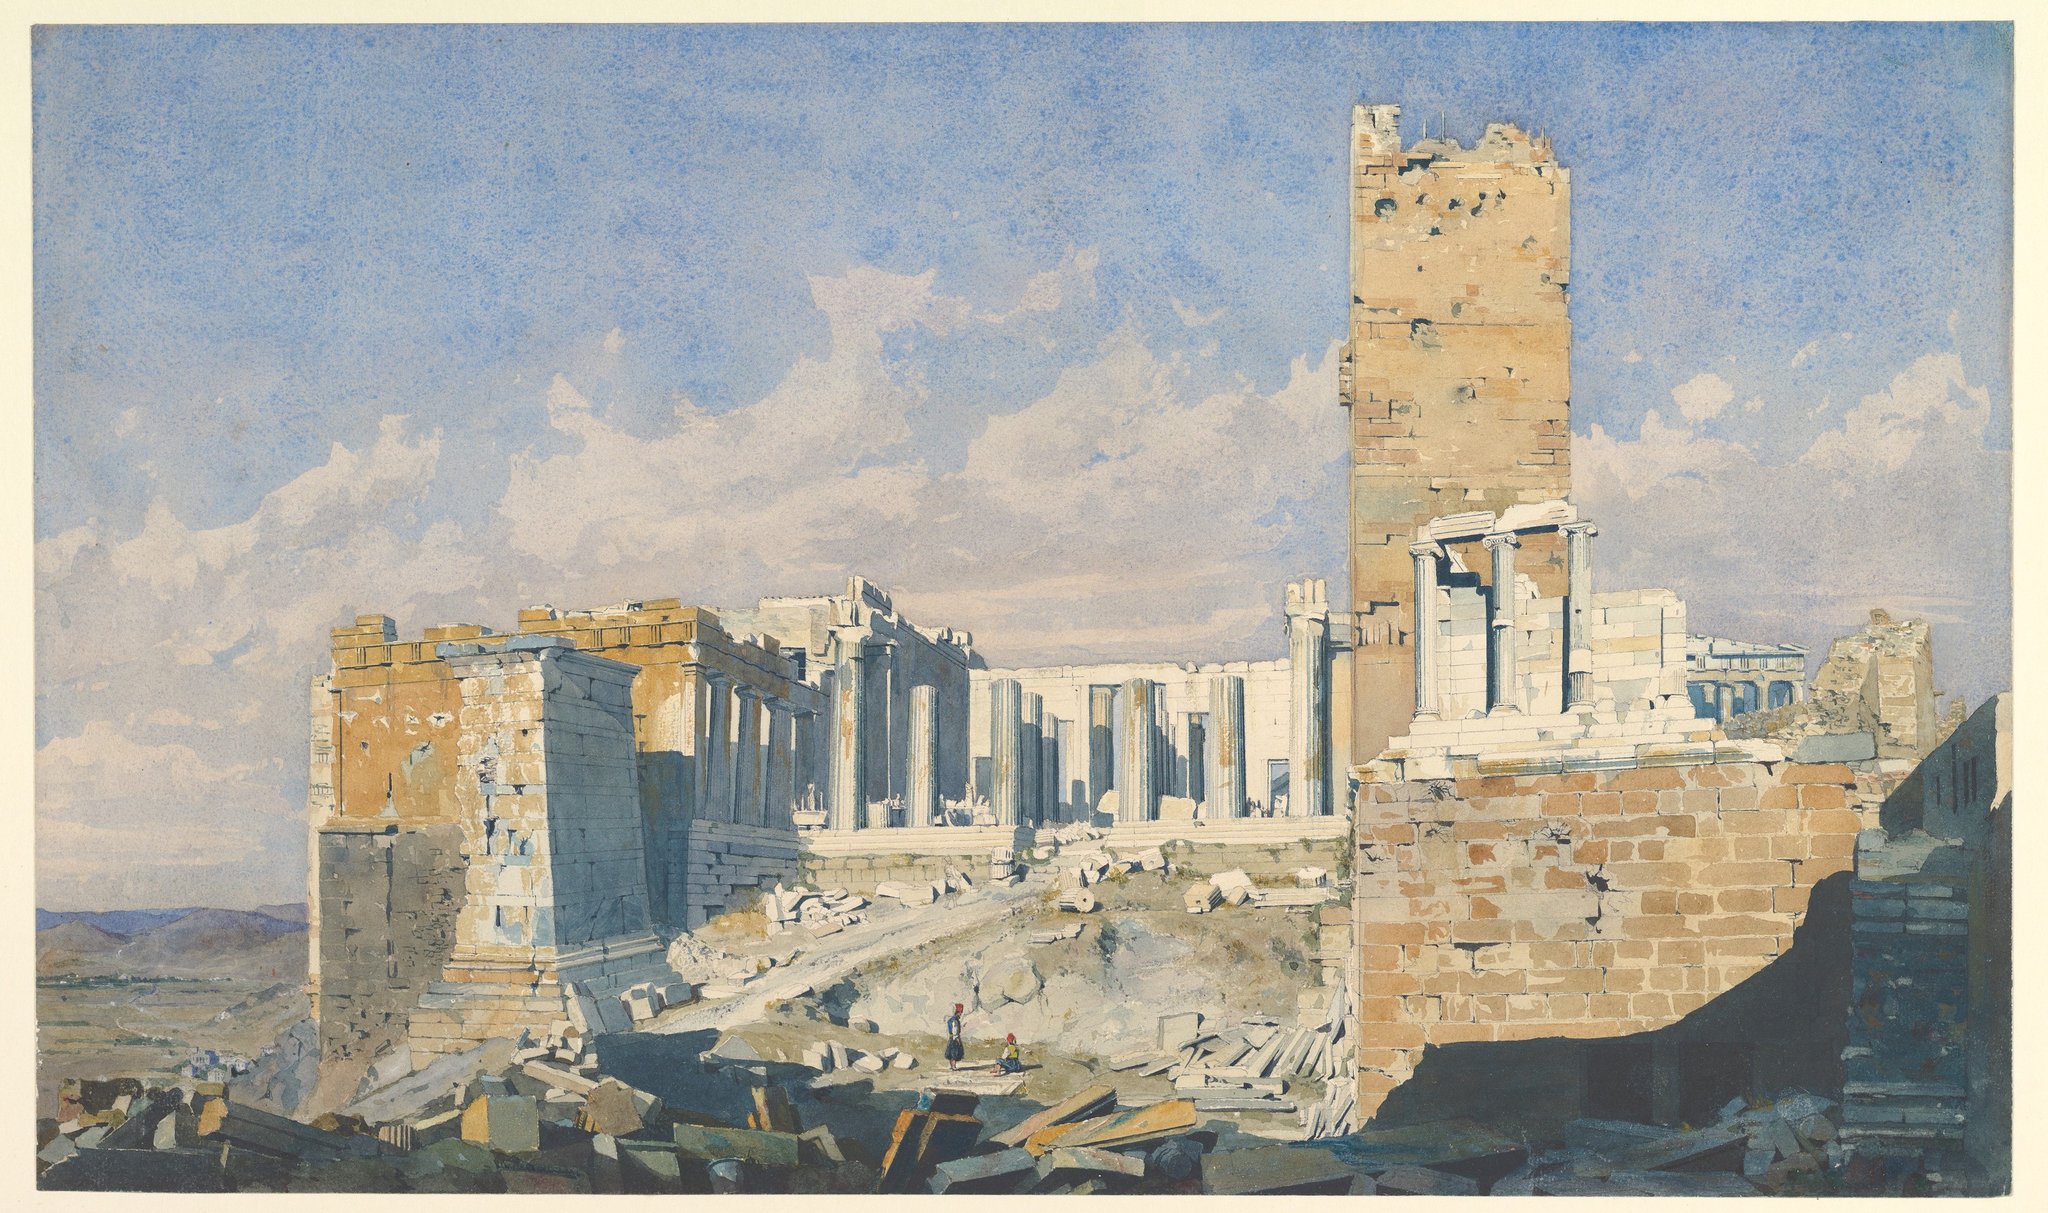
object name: drawing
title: The Acropolis from the West, with the Propylaea and the Temple of Athena Nike, Athens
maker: thomas hartley cromek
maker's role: artist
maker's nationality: british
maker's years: 1809-1873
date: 1834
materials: graphite, watercolor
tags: architecture,columns,temples,ruins